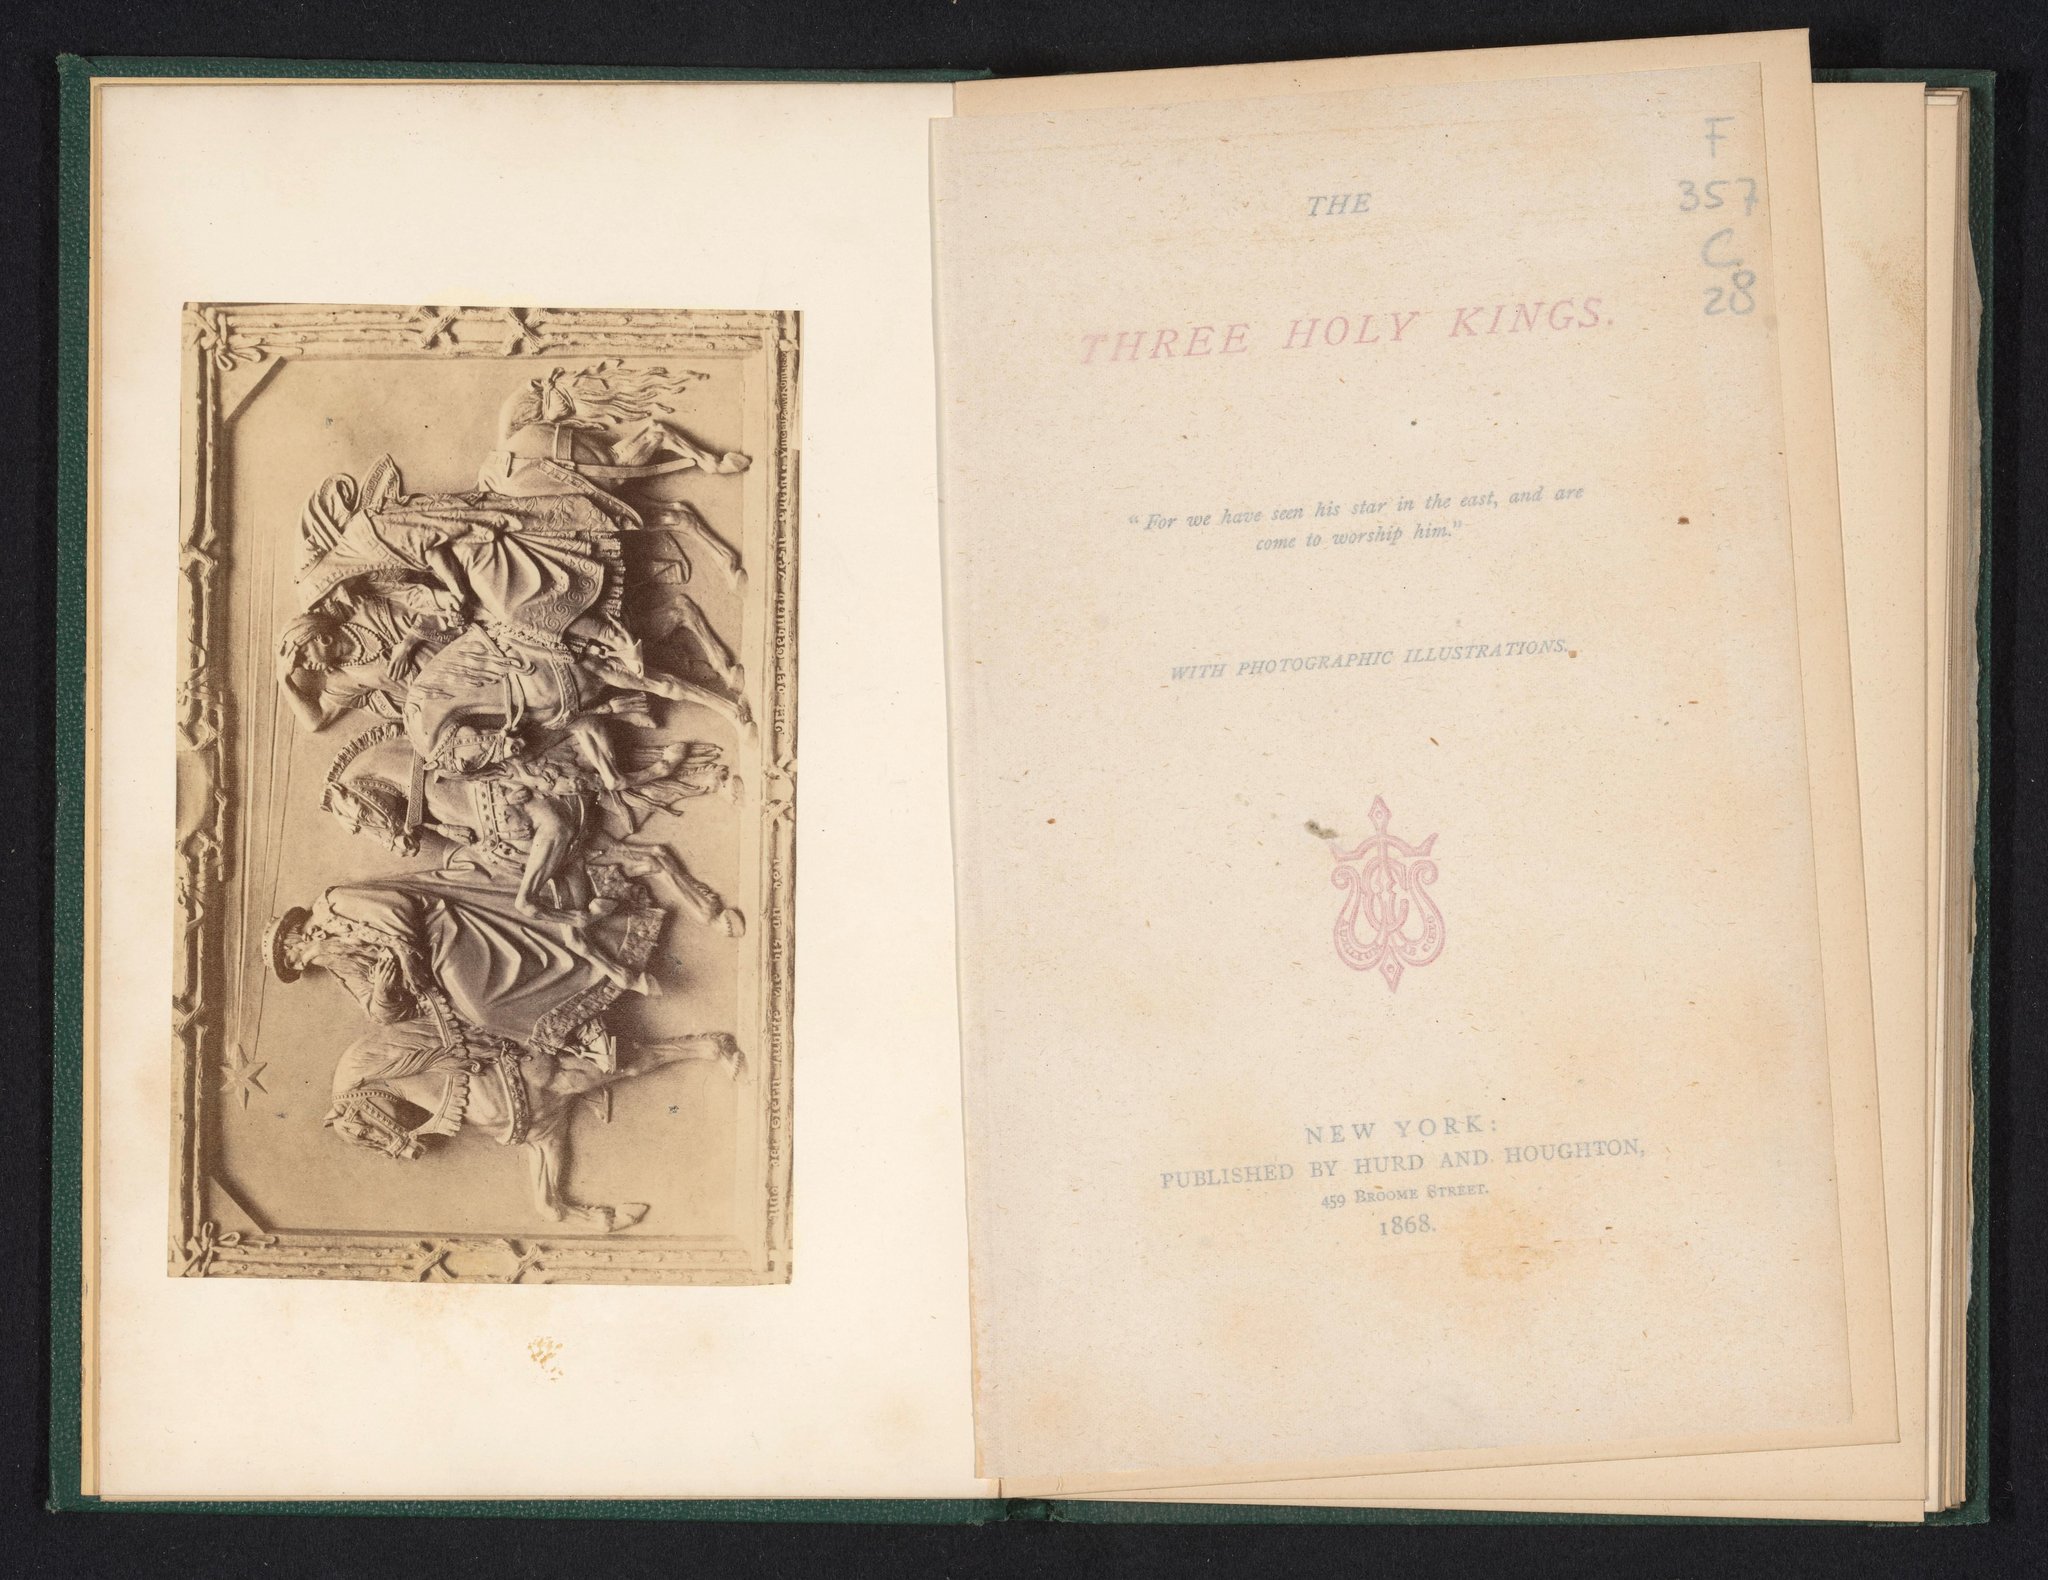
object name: page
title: Reliëf, voorstellende de drie wijzen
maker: Anonymous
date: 1863-1868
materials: photographic support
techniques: albumen print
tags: the story of the three wise men (kings or magi) (matthew 2:1-12), sculpture (+ relief ~ sculpture)